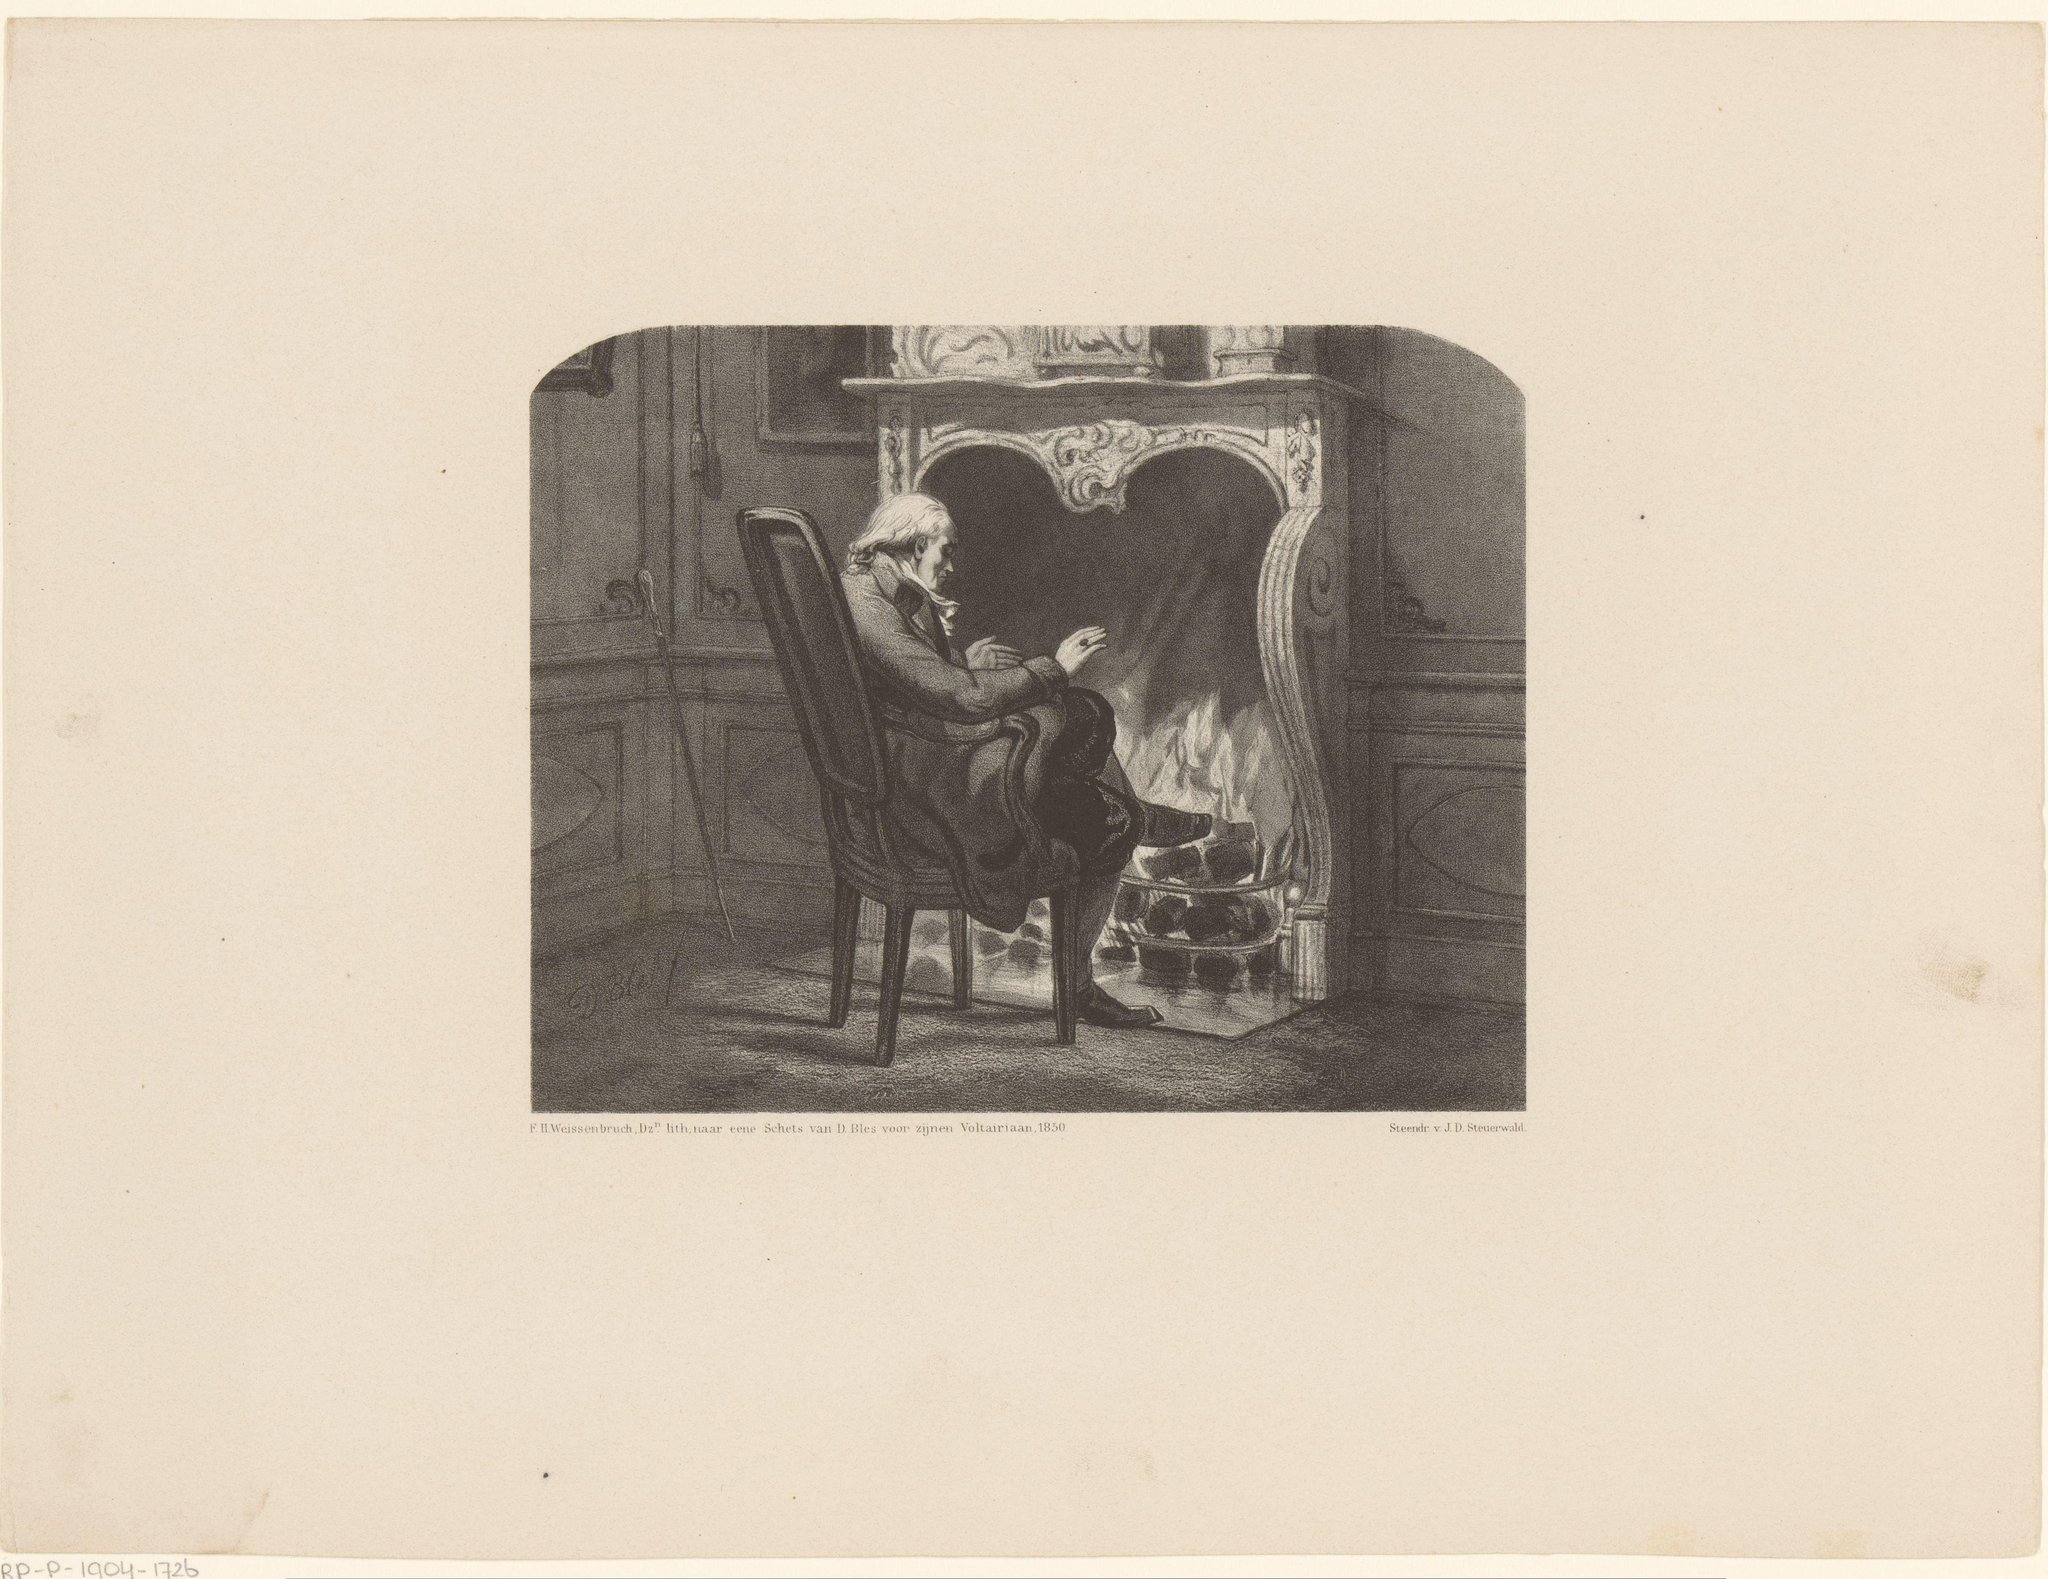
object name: print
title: Oude man warmt zich bij de haard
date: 1850-1863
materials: paper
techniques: lithograph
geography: the hague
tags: warming oneself at a fire (or hearth, stove, fire-pan, brazier)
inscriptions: collector's mark: Lugt 2228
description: Een zittende man zit voor een haard en warmt zijn handen.